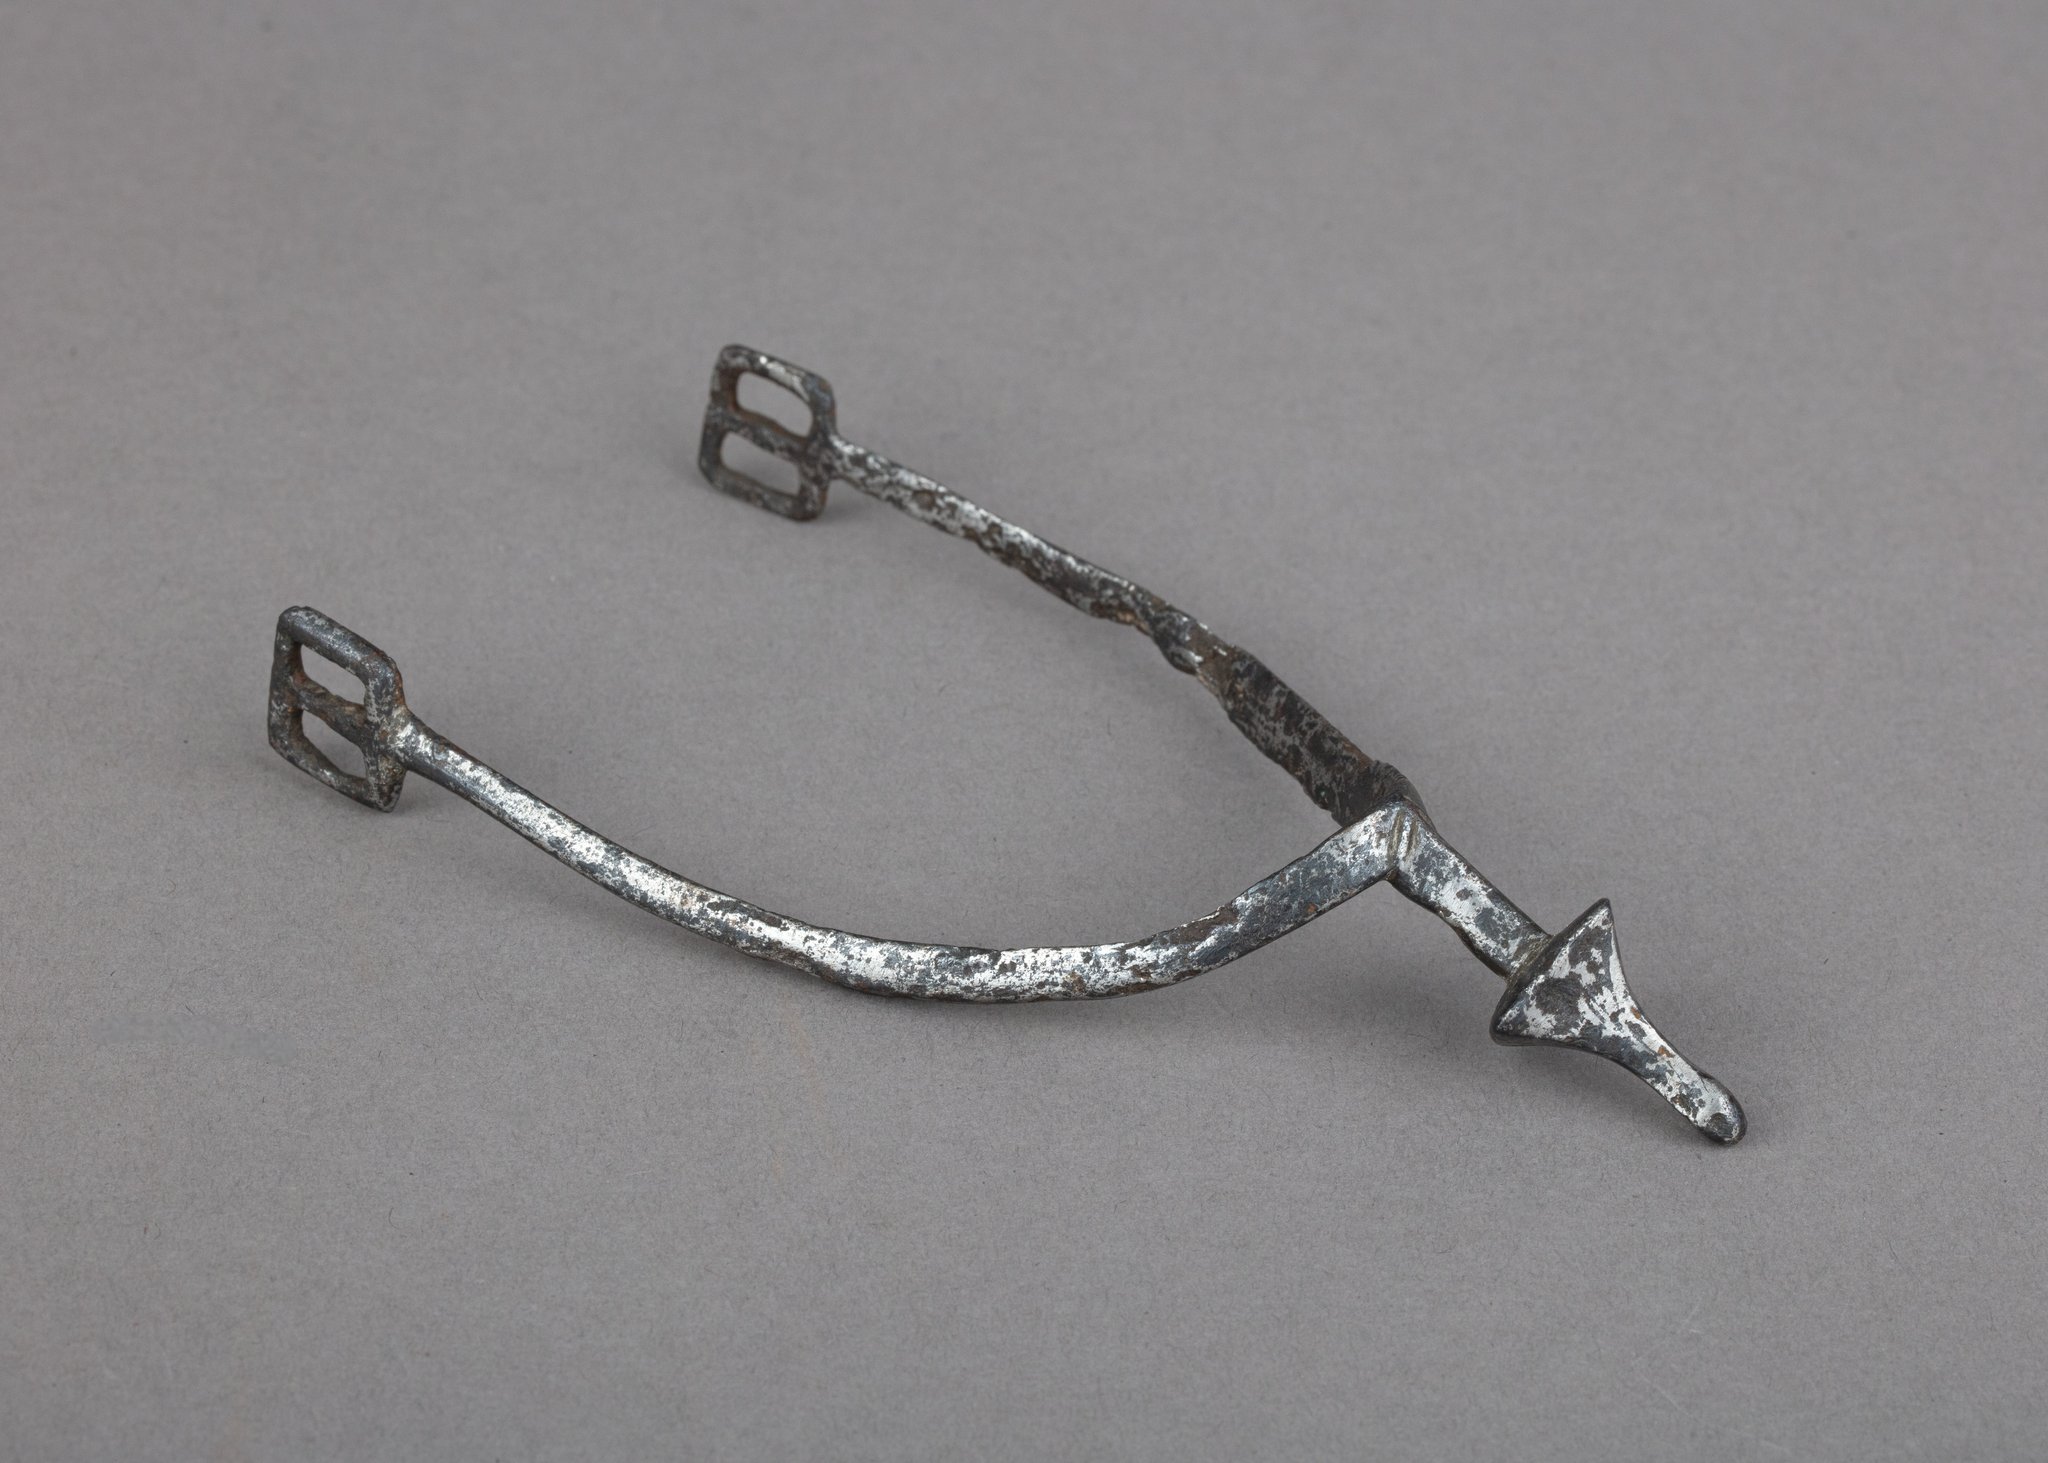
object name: spur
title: Prick Spur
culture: german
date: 1201-1300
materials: metal alloy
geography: germany